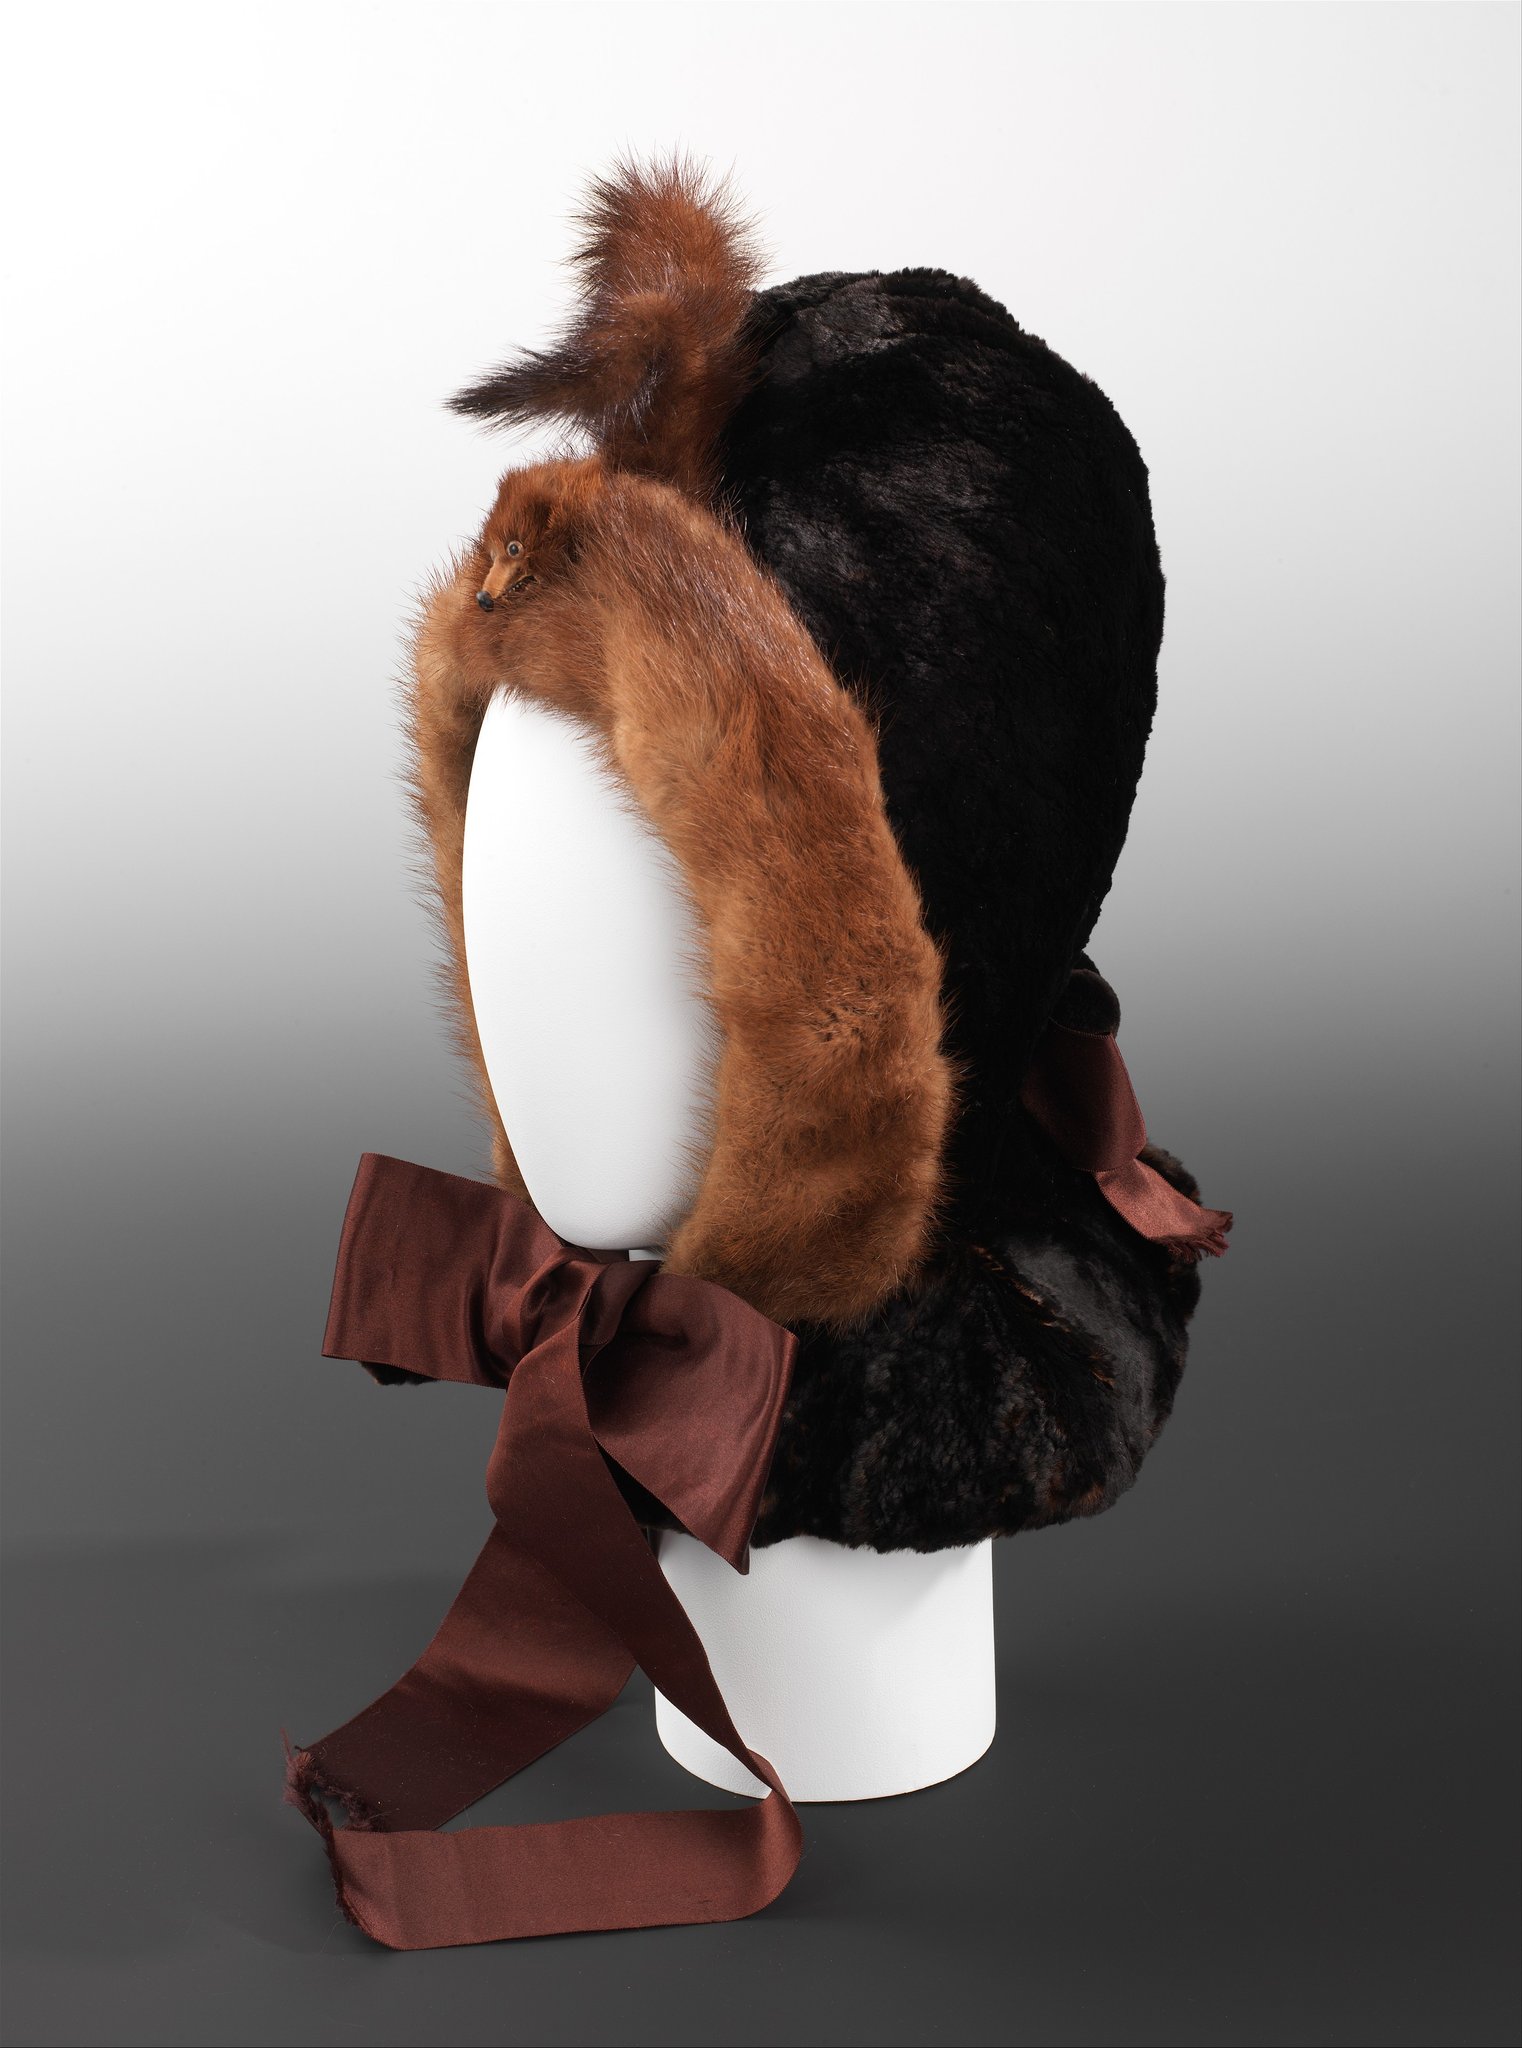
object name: bonnet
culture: american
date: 1870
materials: fur, silk